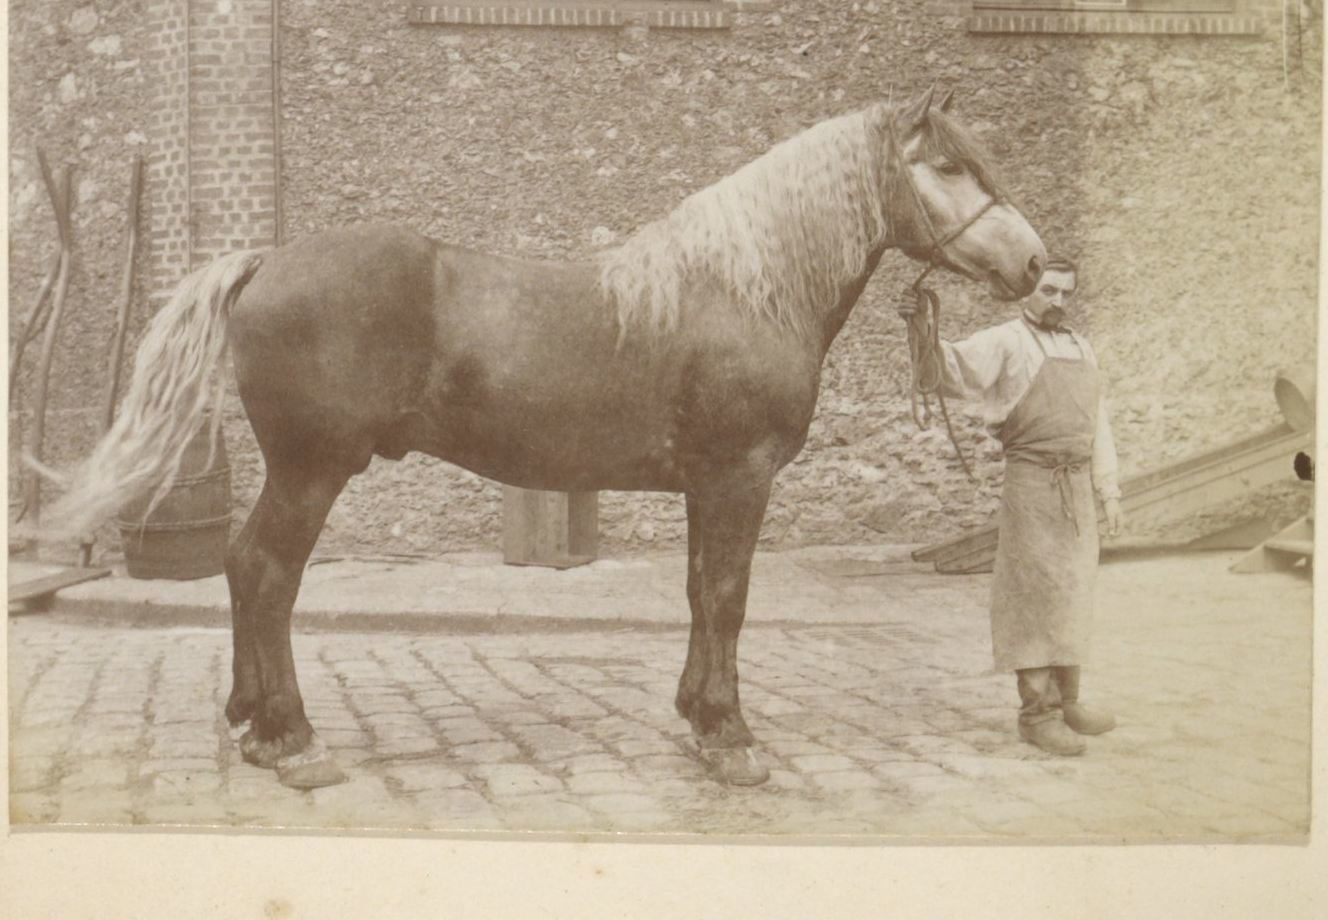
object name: photograph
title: Man houdt paarden bij de teugels, mogelijk op het terrein van distilleerderij Delizy & Doistau Fils in Pantin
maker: Anonymous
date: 1900-1910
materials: paper, photographic support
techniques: albumen print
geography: pantin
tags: horse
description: Onderdeel van Fotoalbum van een Franse amateurfotograaf met opnames van een familie, distilleerderij Delizy & Doistau Fils, het leger en bezienswaardigheden in Frankrijk.